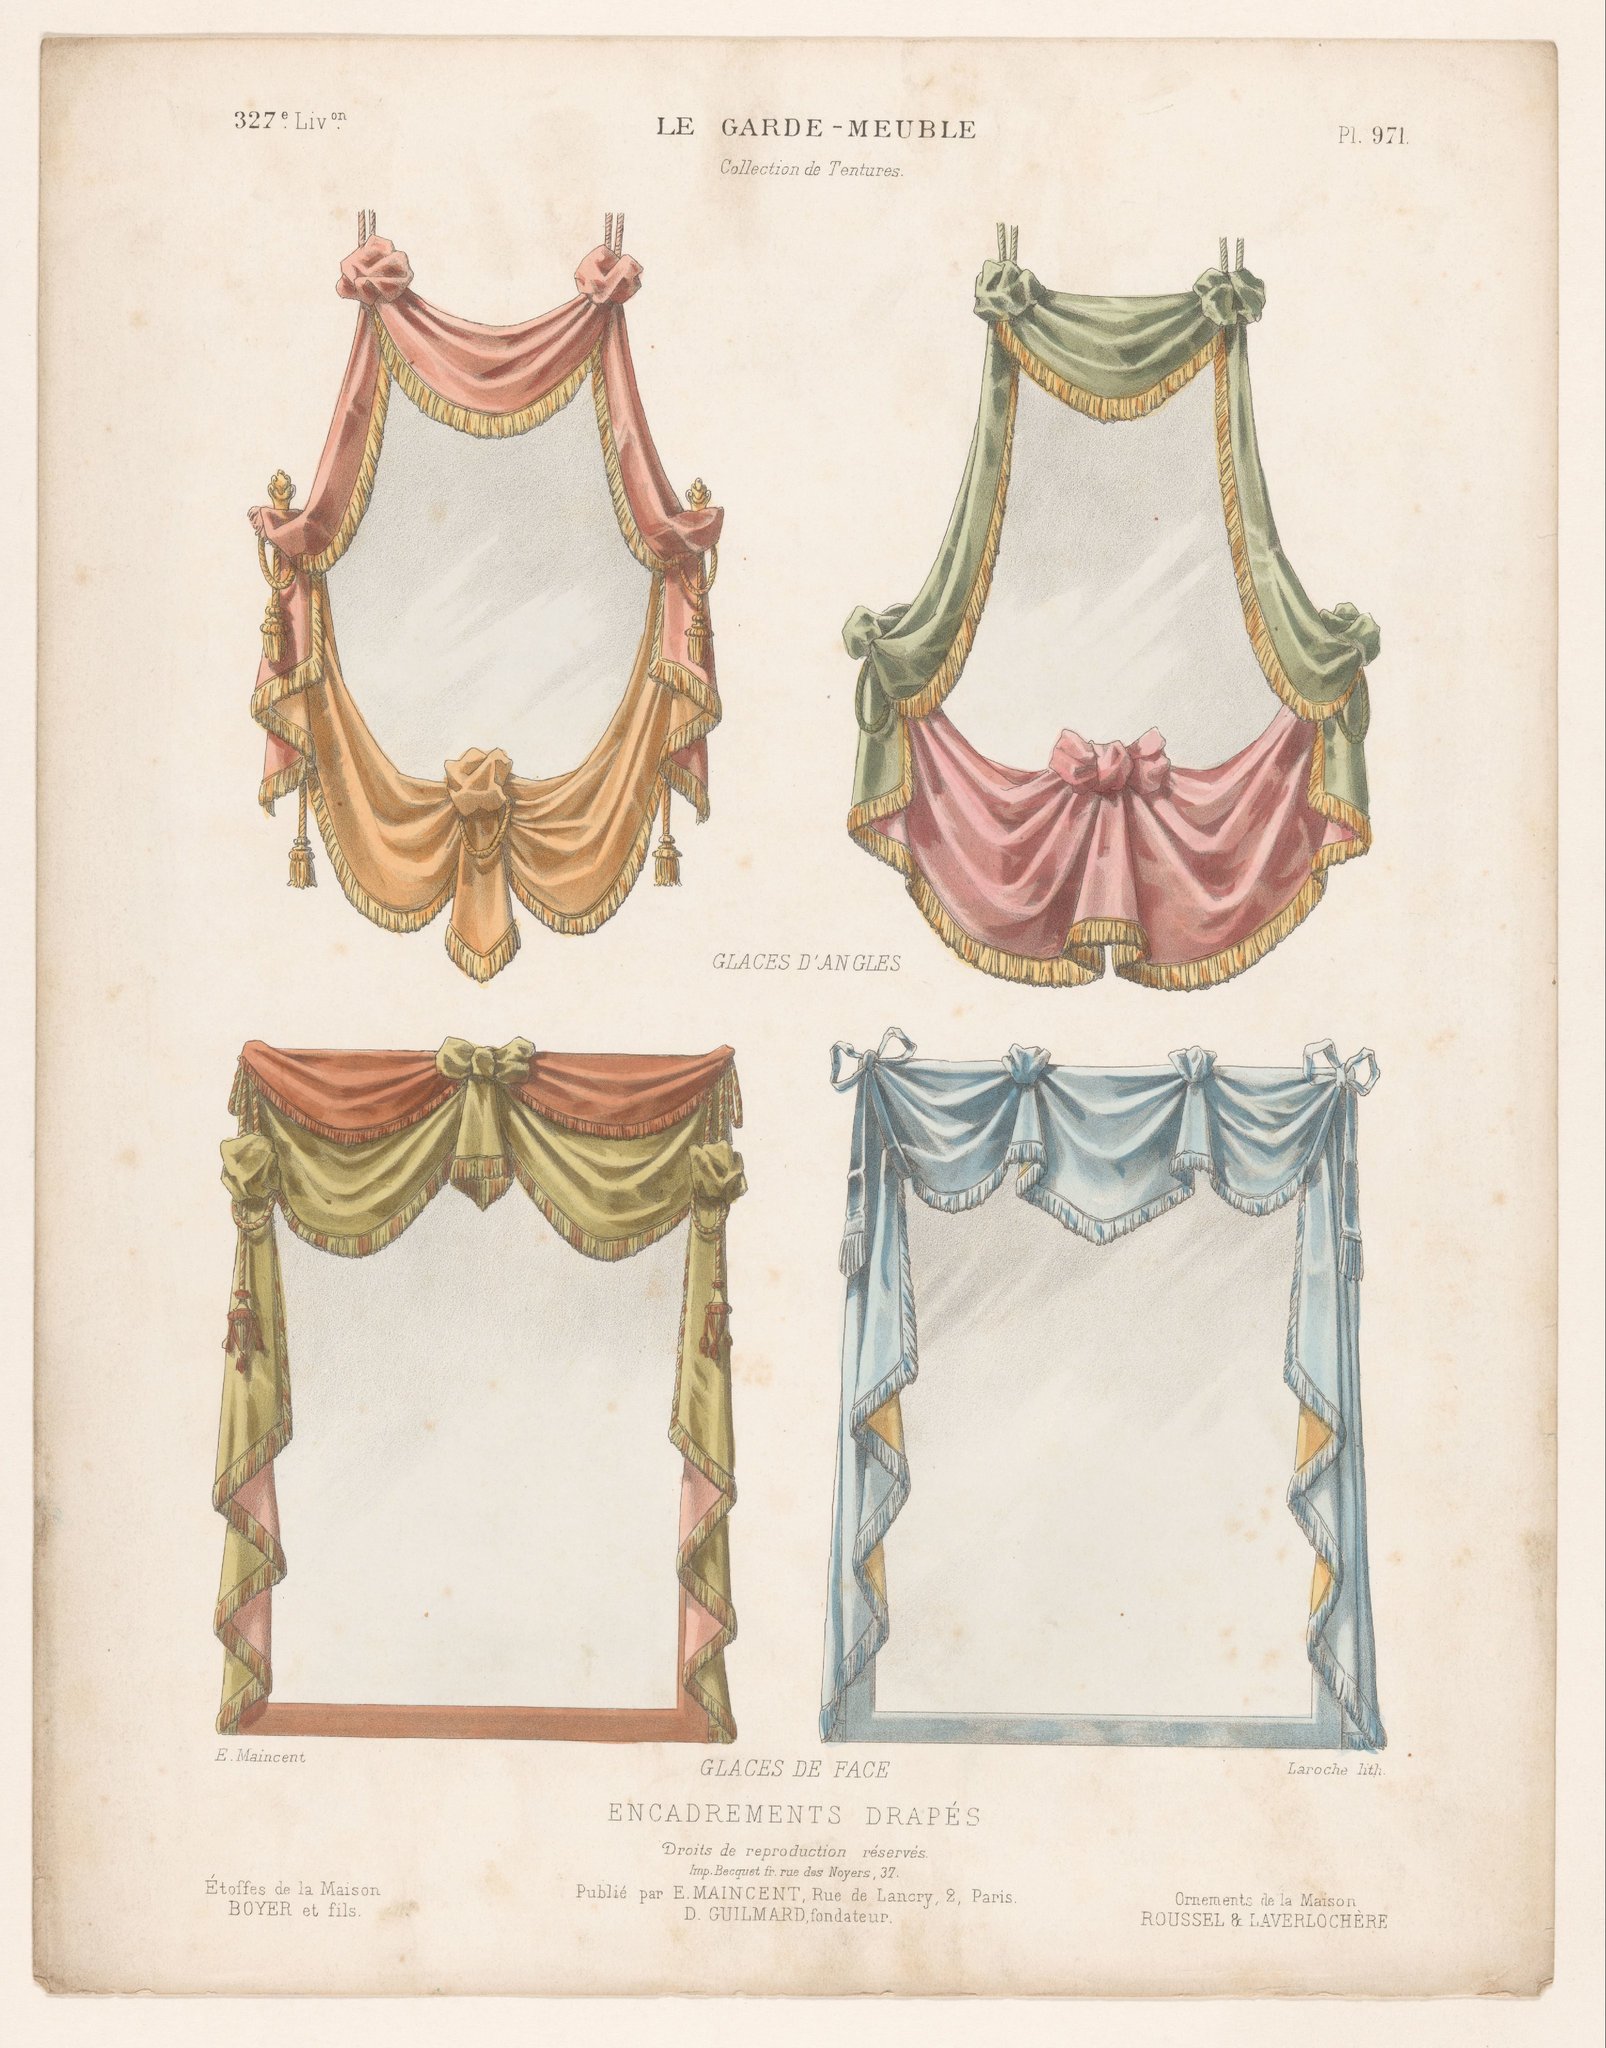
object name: print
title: Spiegels met draperieën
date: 1885-1895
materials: paper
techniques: hand coloring, lithograph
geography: paris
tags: decorations (interior of the house), mirror, hangings and drapery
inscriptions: : ‘Droits de reproduction réservés.’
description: Vier spiegels met draperieën om de lijsten. Prent uit 327e Livraison.